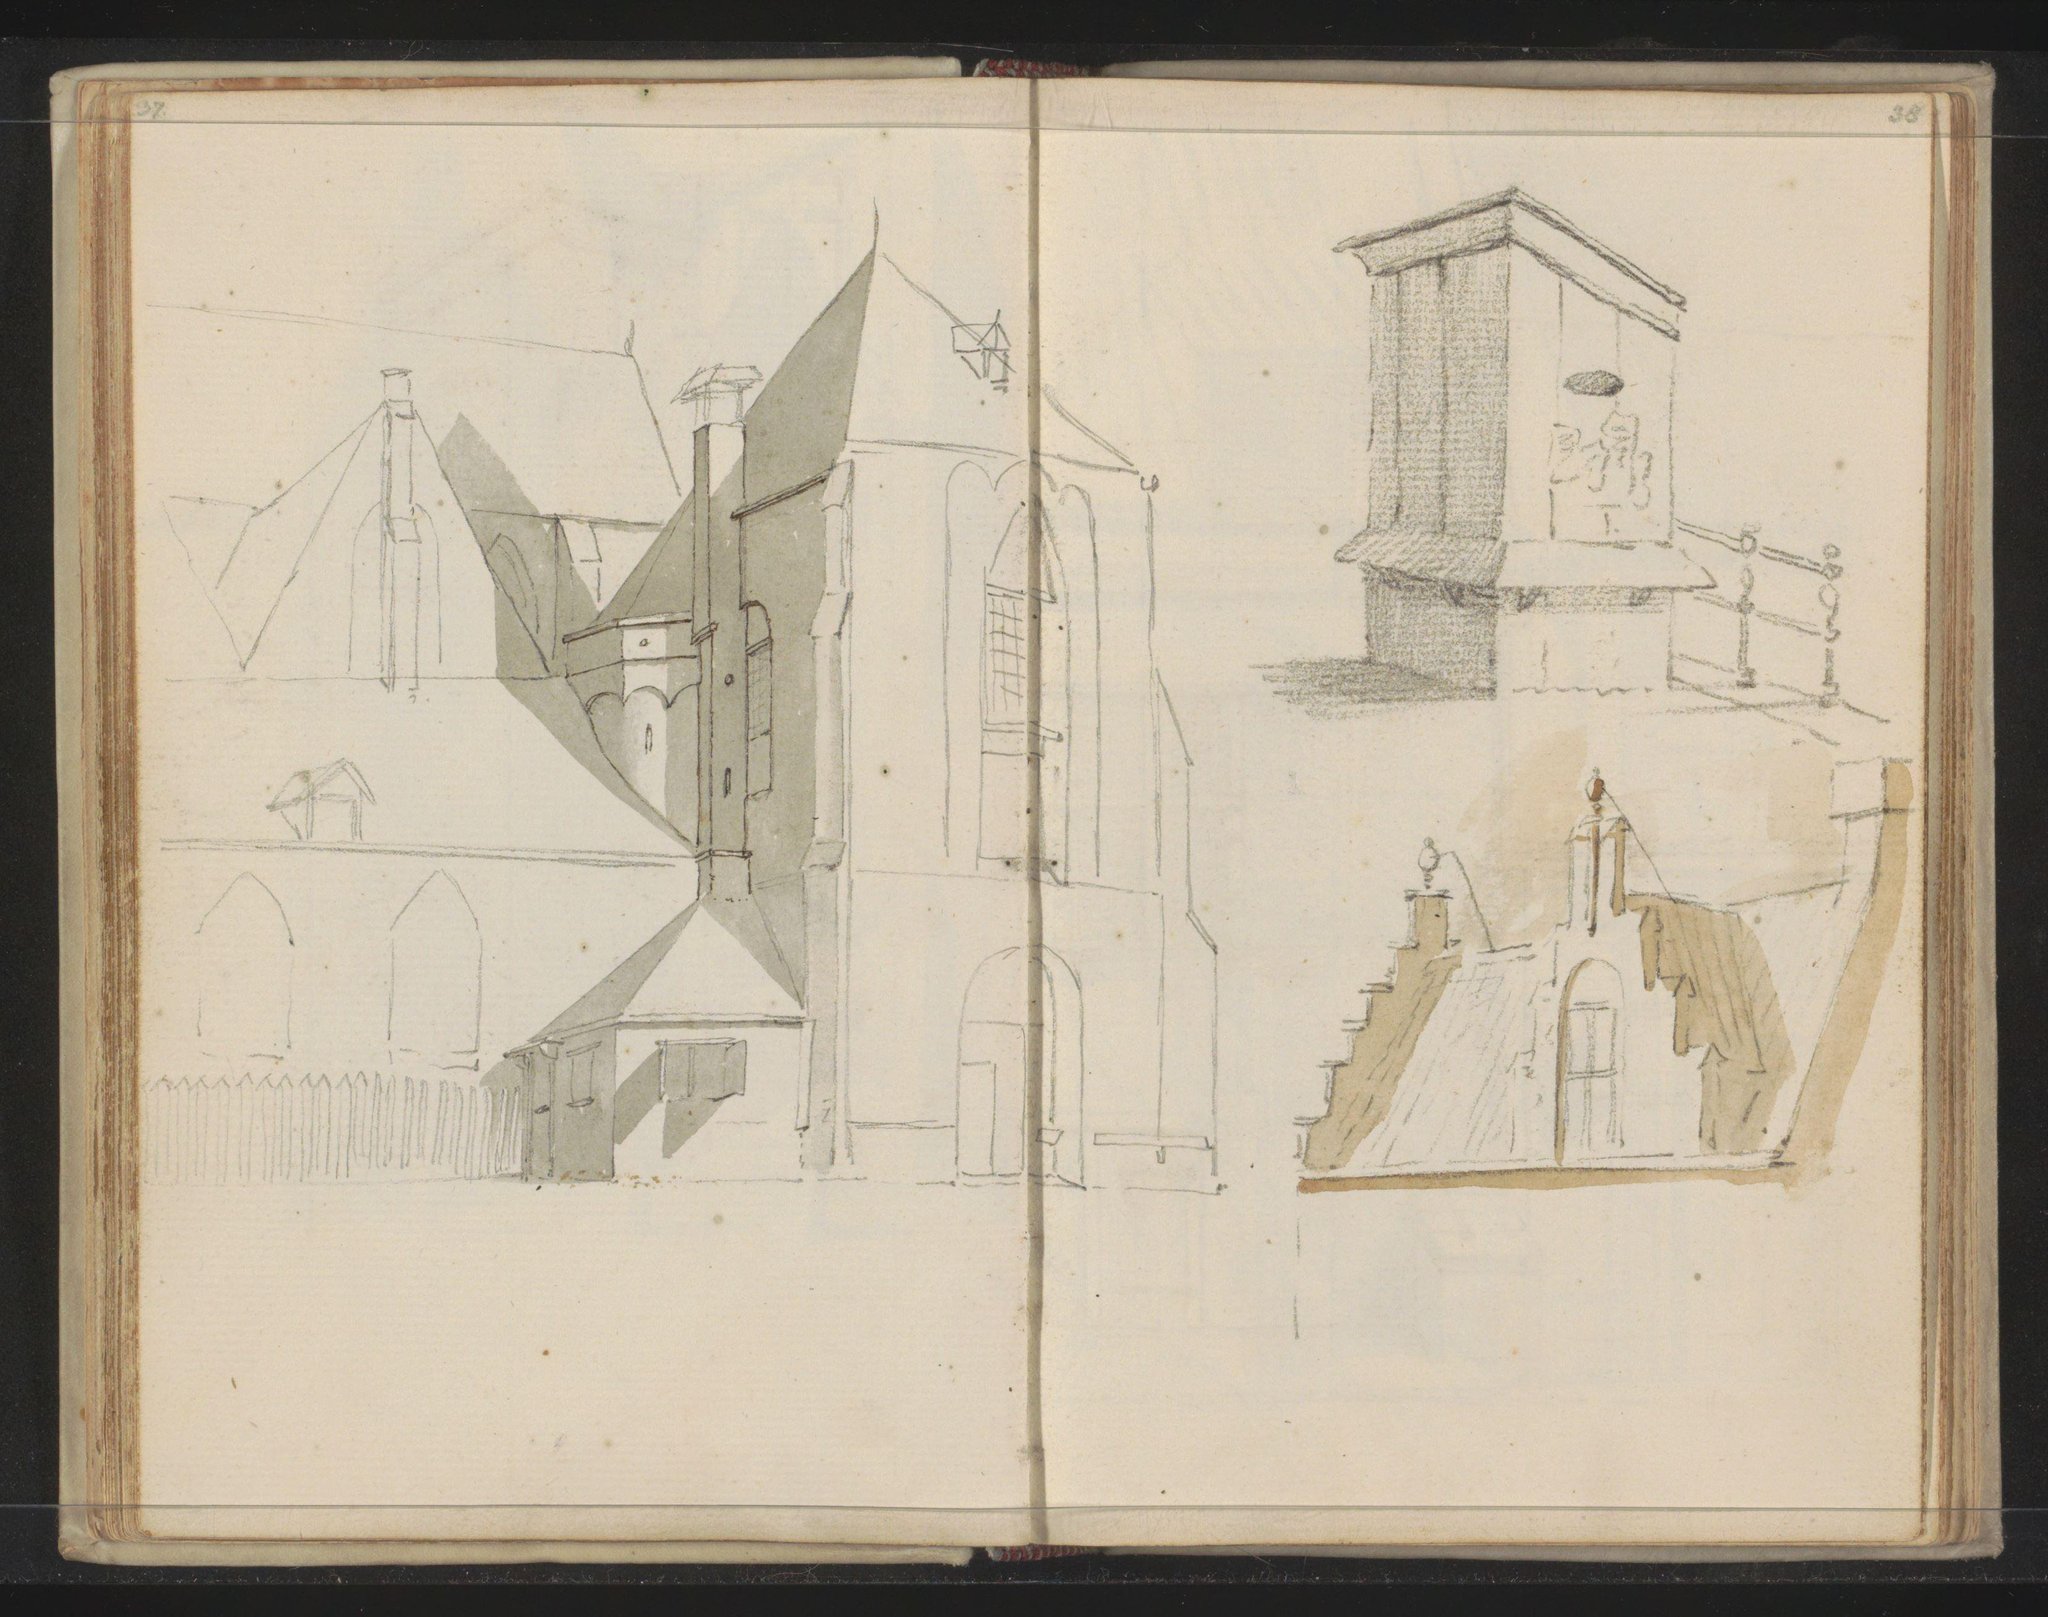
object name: sketchbook leaf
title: Exterieur van een kerk, een trapgevel en schoorsteen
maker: johannes huibert prins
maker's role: draughtsman, painter, print maker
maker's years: 1757-1806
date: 1783-1797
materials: ink, paper, pencil, watercolor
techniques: brush, pen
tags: chimney, decorated gable, church (exterior)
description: Pagina 37 en 38 uit een schetsboek met 175 pagina's.